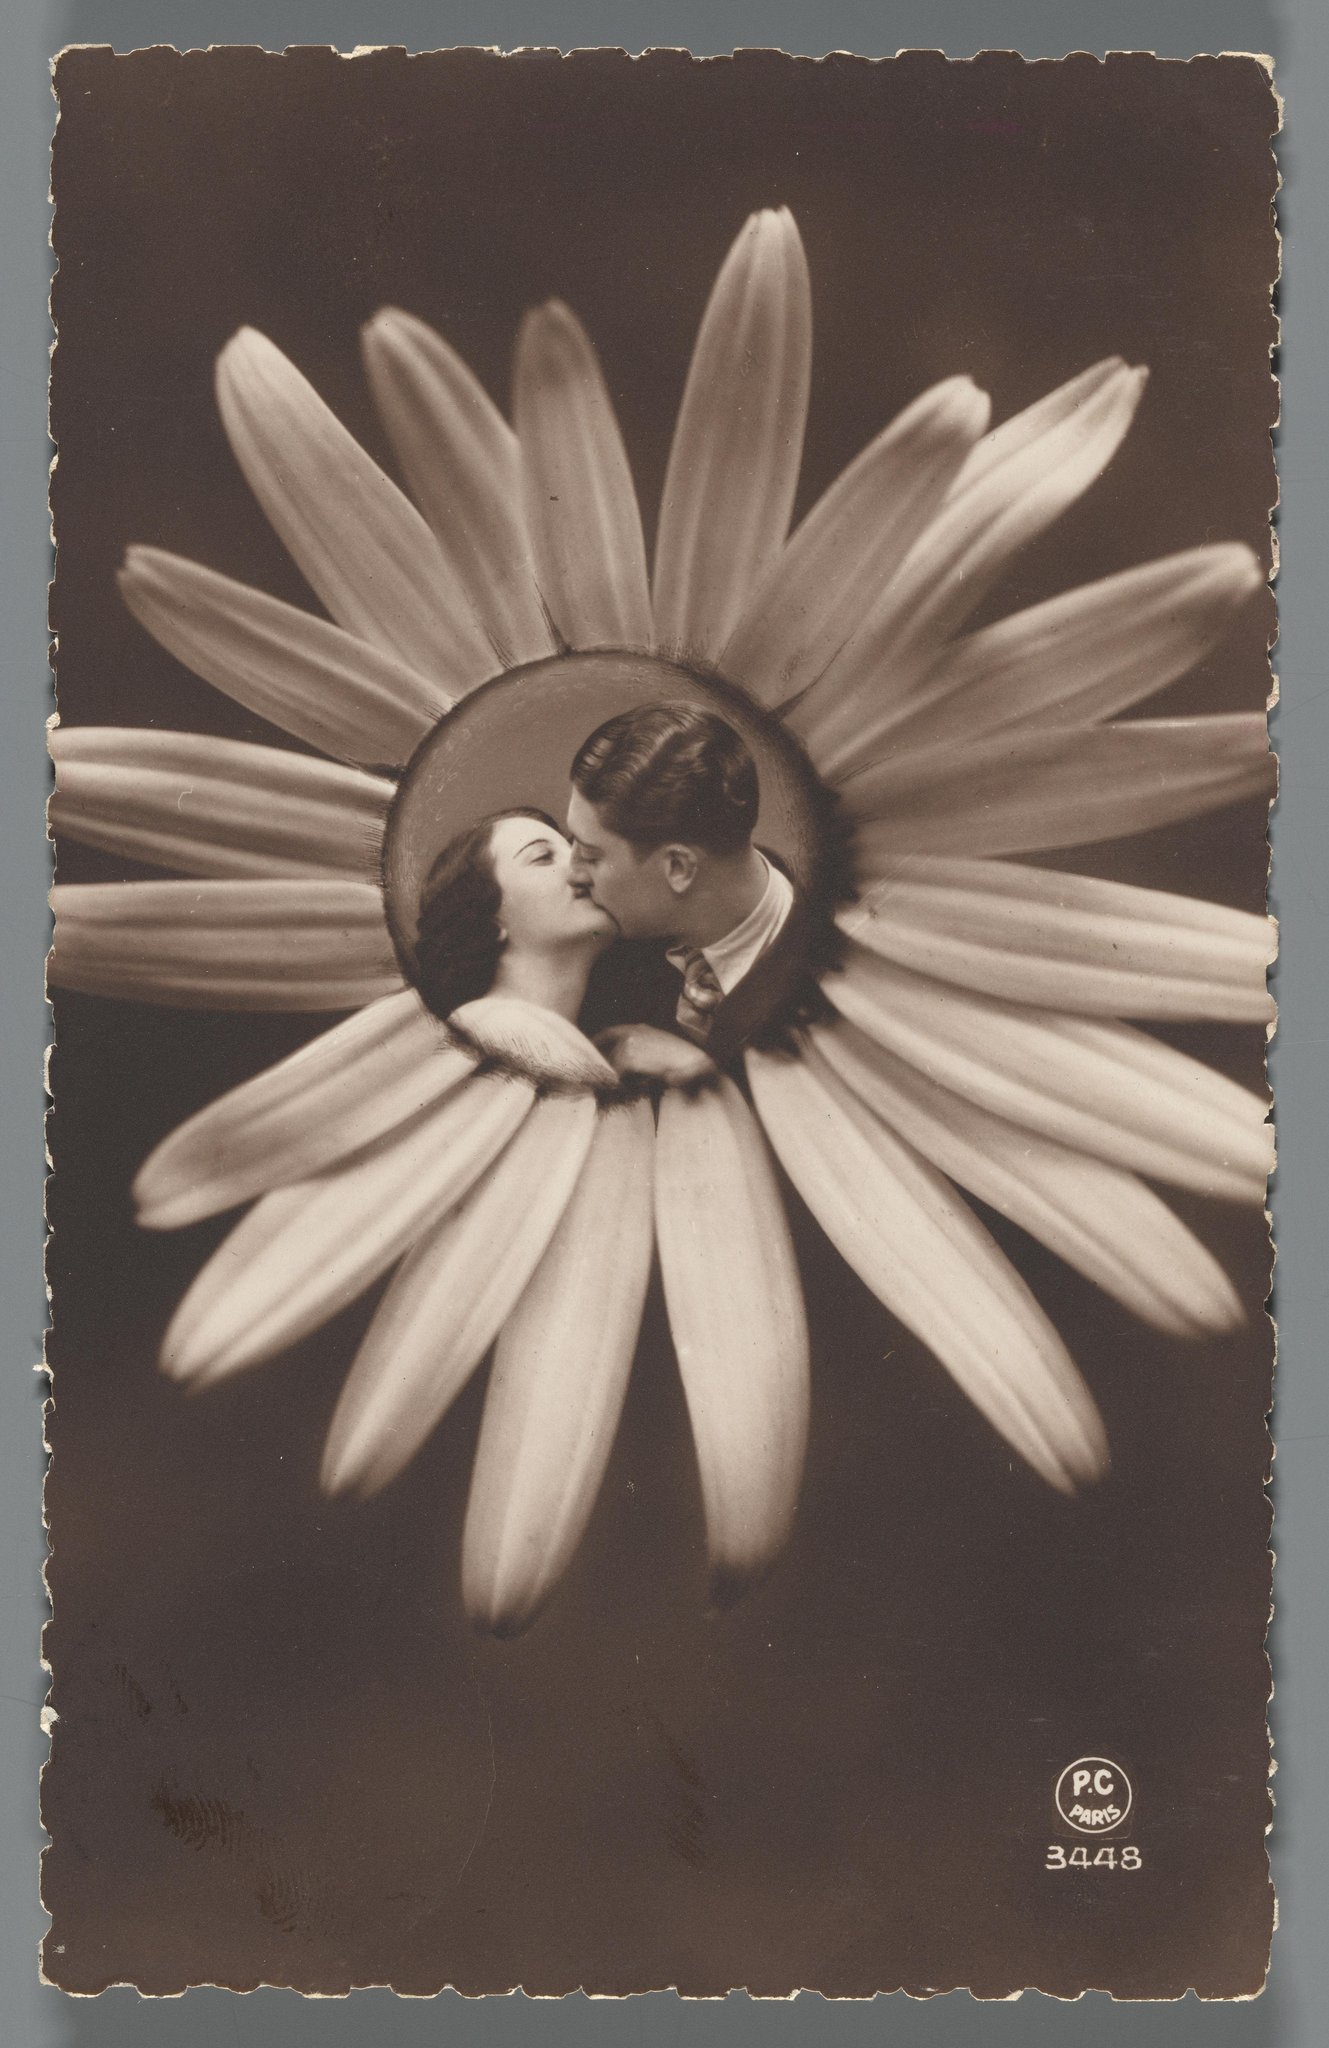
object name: photograph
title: Portret van een kussende vrouw en man, gemonteerd in een bloem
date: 1930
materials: photographic support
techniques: gelatin silver print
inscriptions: inscription: ‘P.C. / PARIS / 3448’, inscription: ‘Made in France / P-C / PARIS’, inscription: ‘[…] 7-11-’31 […]’